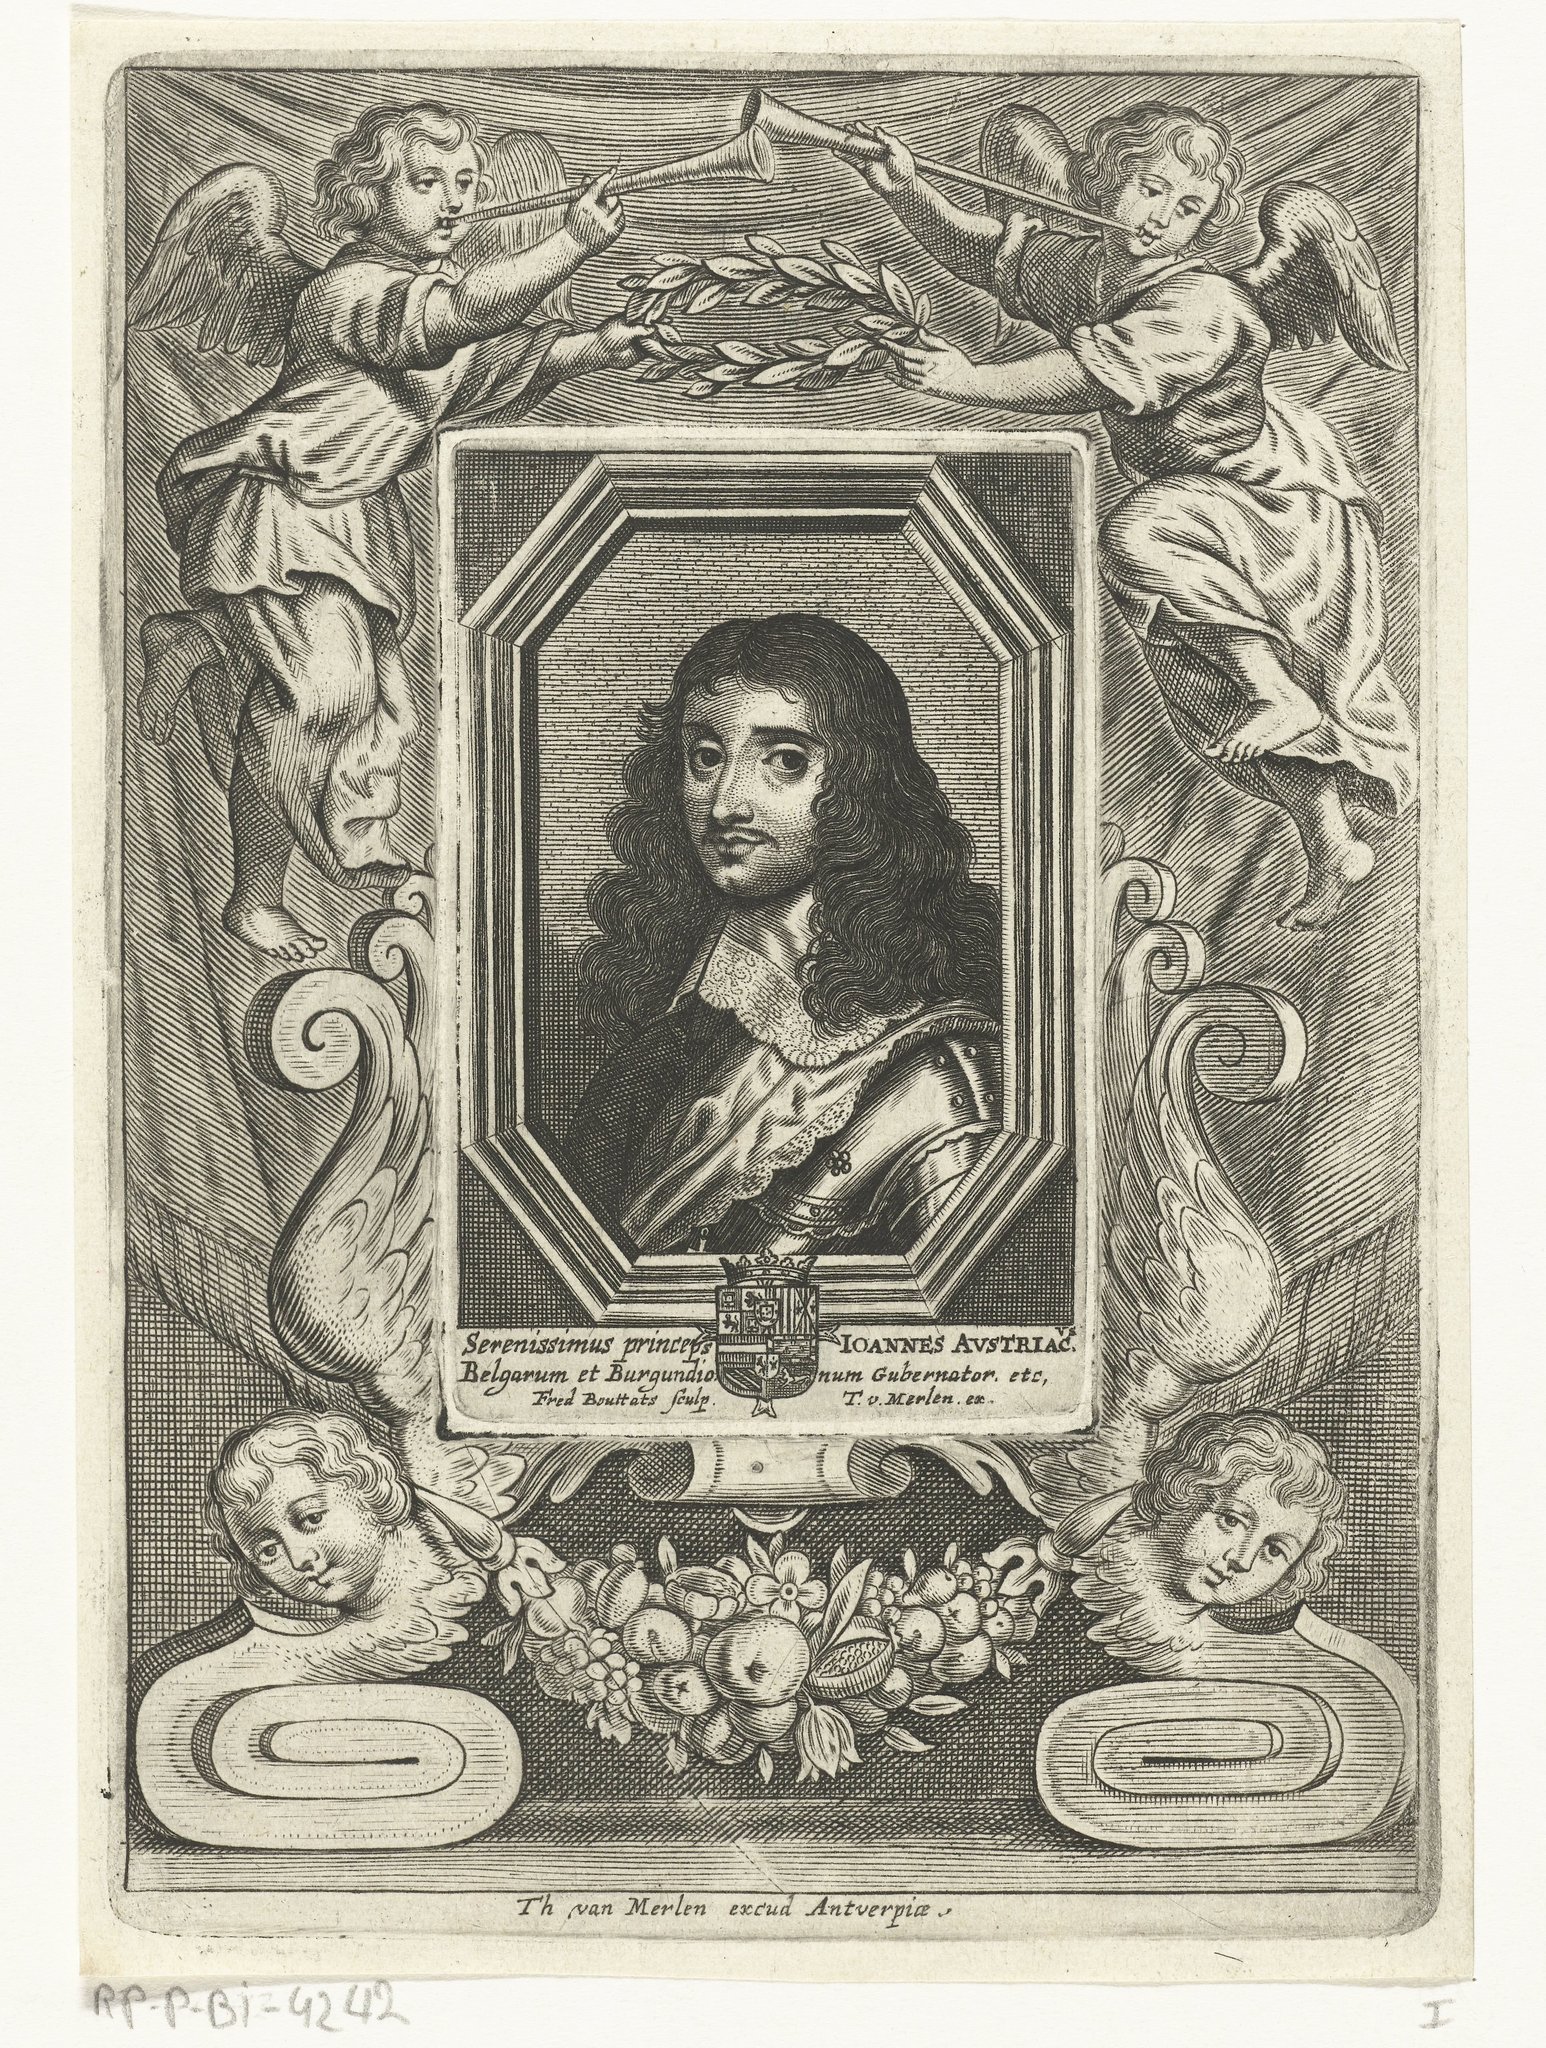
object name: print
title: Portret van Don Juan II van Oostenrijk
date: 1656-1676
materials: paper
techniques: engraving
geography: antwerp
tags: cupids: 'amores', 'amoretti', 'putti'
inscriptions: collector's mark: Lugt 2228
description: Portret in een octagonale lijst van Don Juan II van Oostenrijk, landvoogd van de Zuidelijke Nederlanden. Buste naar links. Don Juan draagt een harnas. Het portret staat in een rechthoekig kader tussen twee engelen. Beiden hebben een trompet vast en ze houden een lauwerkrans boven het portret.. De prent heeft een Latijns onderschrift met de naam van de geportretteerde.